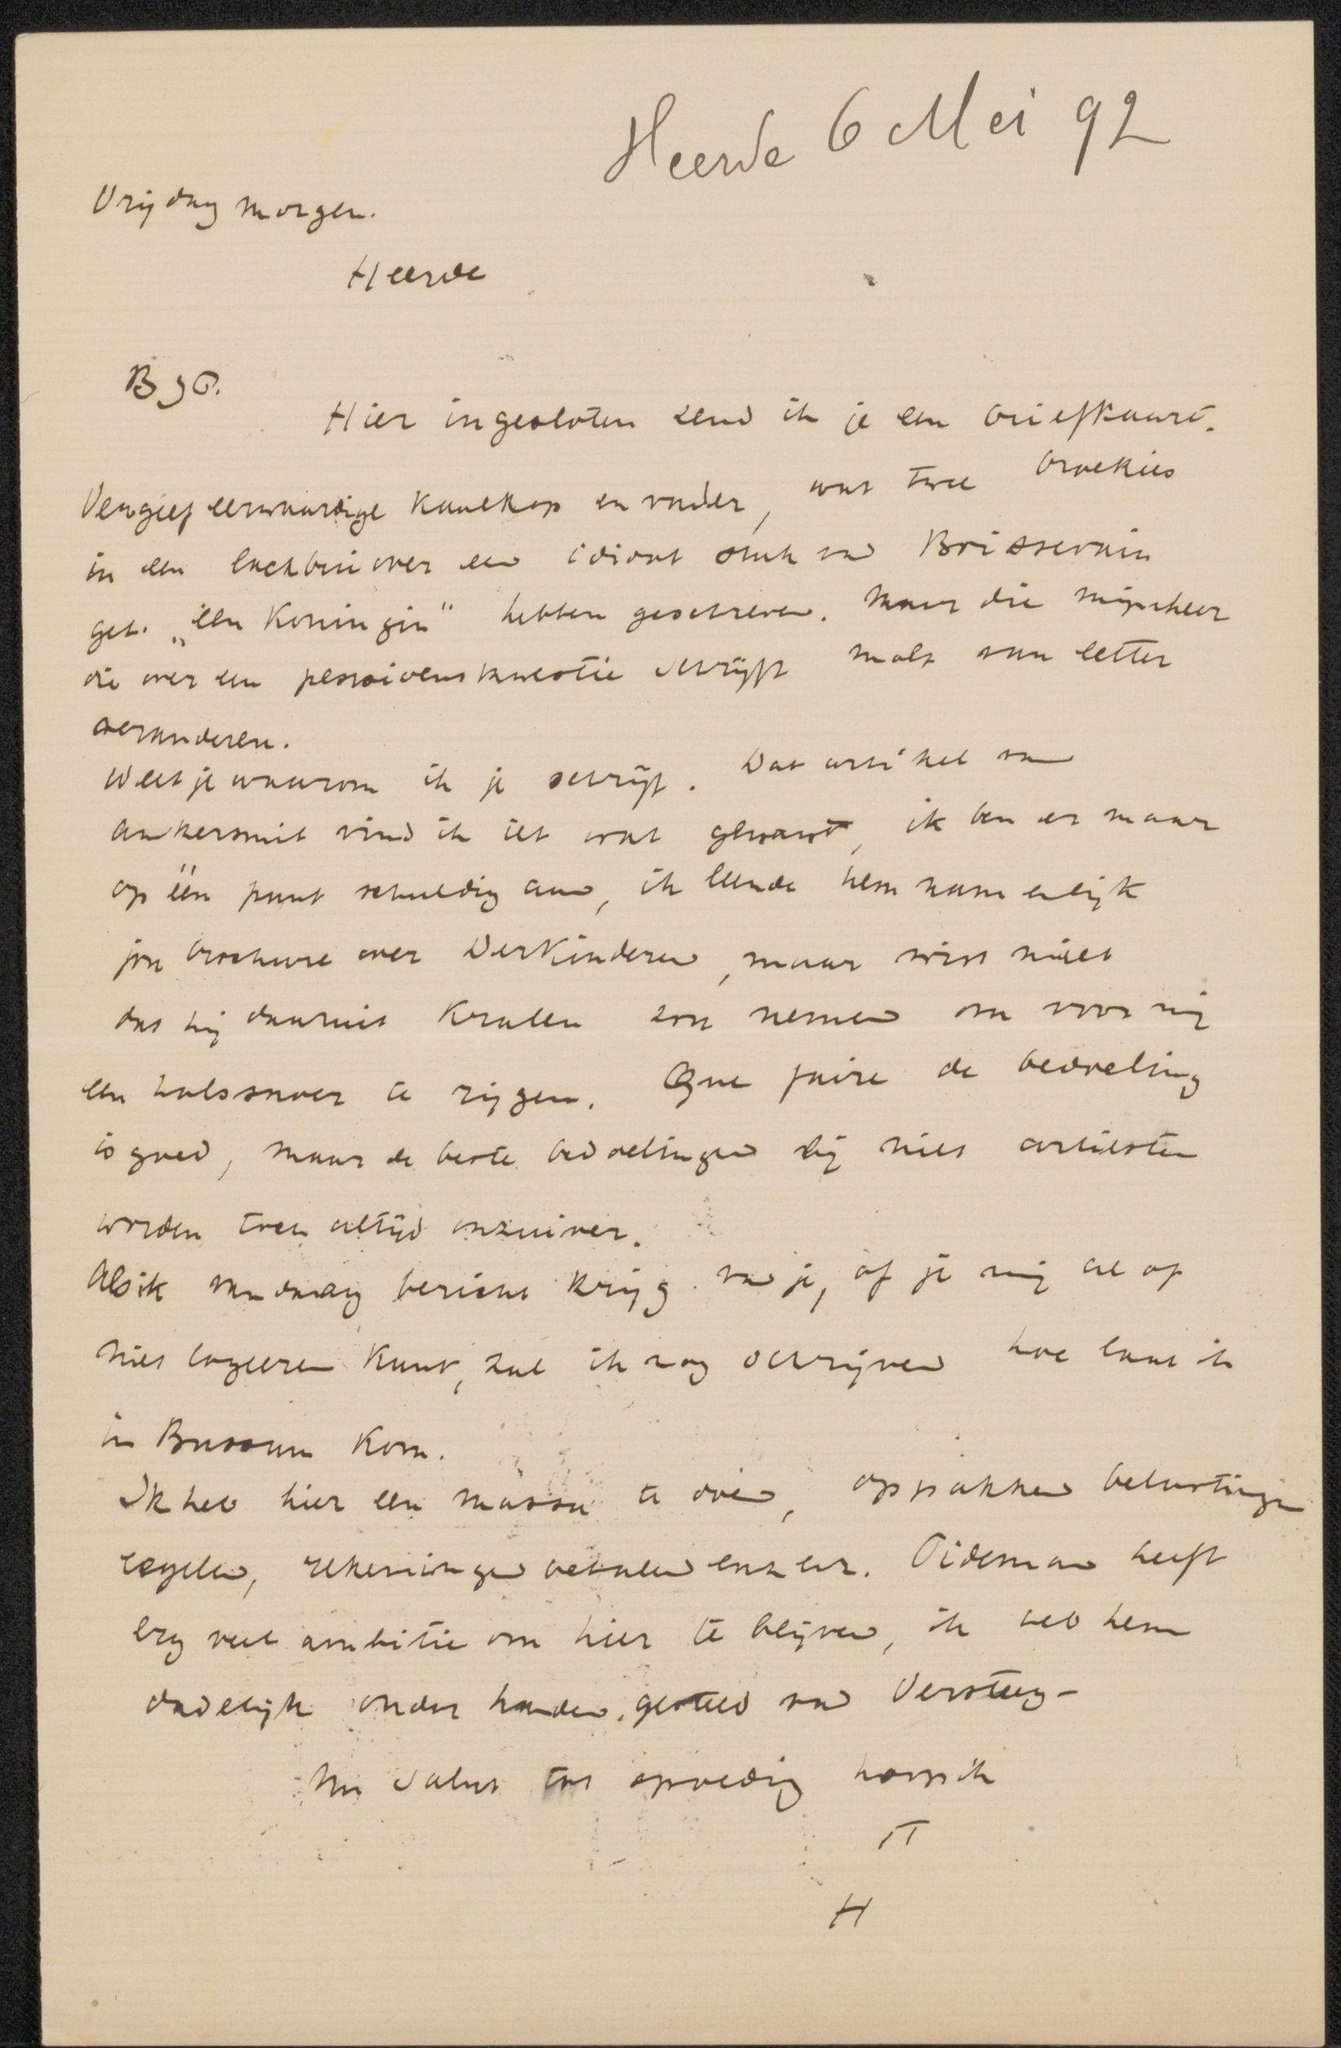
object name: letter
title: Brief aan Jan Veth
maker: richard nicolaüs roland holst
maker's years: 1868-1938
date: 1878-1925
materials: ink, paper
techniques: pen, writing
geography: heerde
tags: dordrecht, jan veth, den bosch, painter, print maker, draughtsman, antoon derkinderen, amsterdam, johan frederik ankersmit, hoorn (north holland), pet tideman, printed matter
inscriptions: collector's mark: ‘RPK’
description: Brief gedateerd 6 Mei 92 in latere hand.